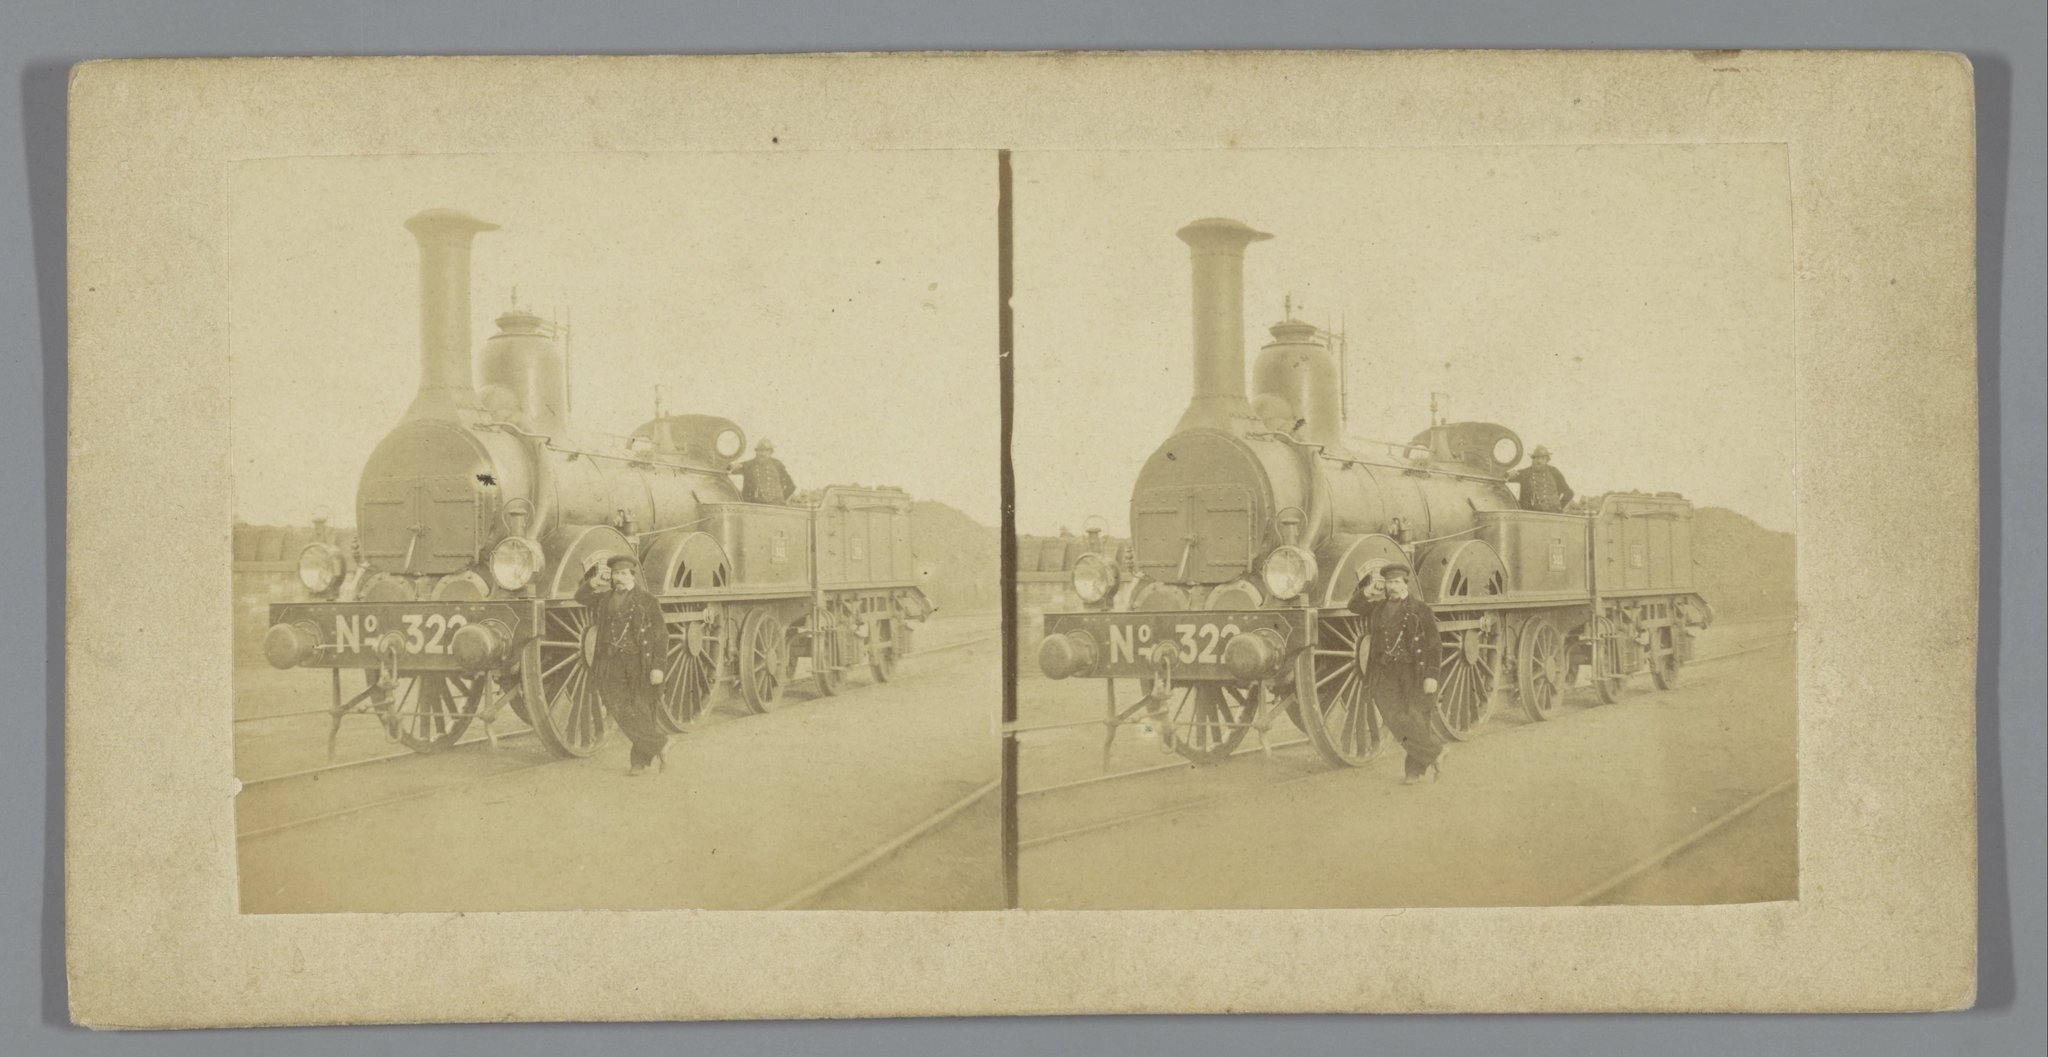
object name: stereograph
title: Stoomlocomotief 322 met machinisten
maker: Anonymous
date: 1857-1870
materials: cardboard, paper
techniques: albumen print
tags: railway, train, steam locomotive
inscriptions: inscription: ‘P’, number: ‘132’, inscription: ‘as/ 30’, number: ‘29’